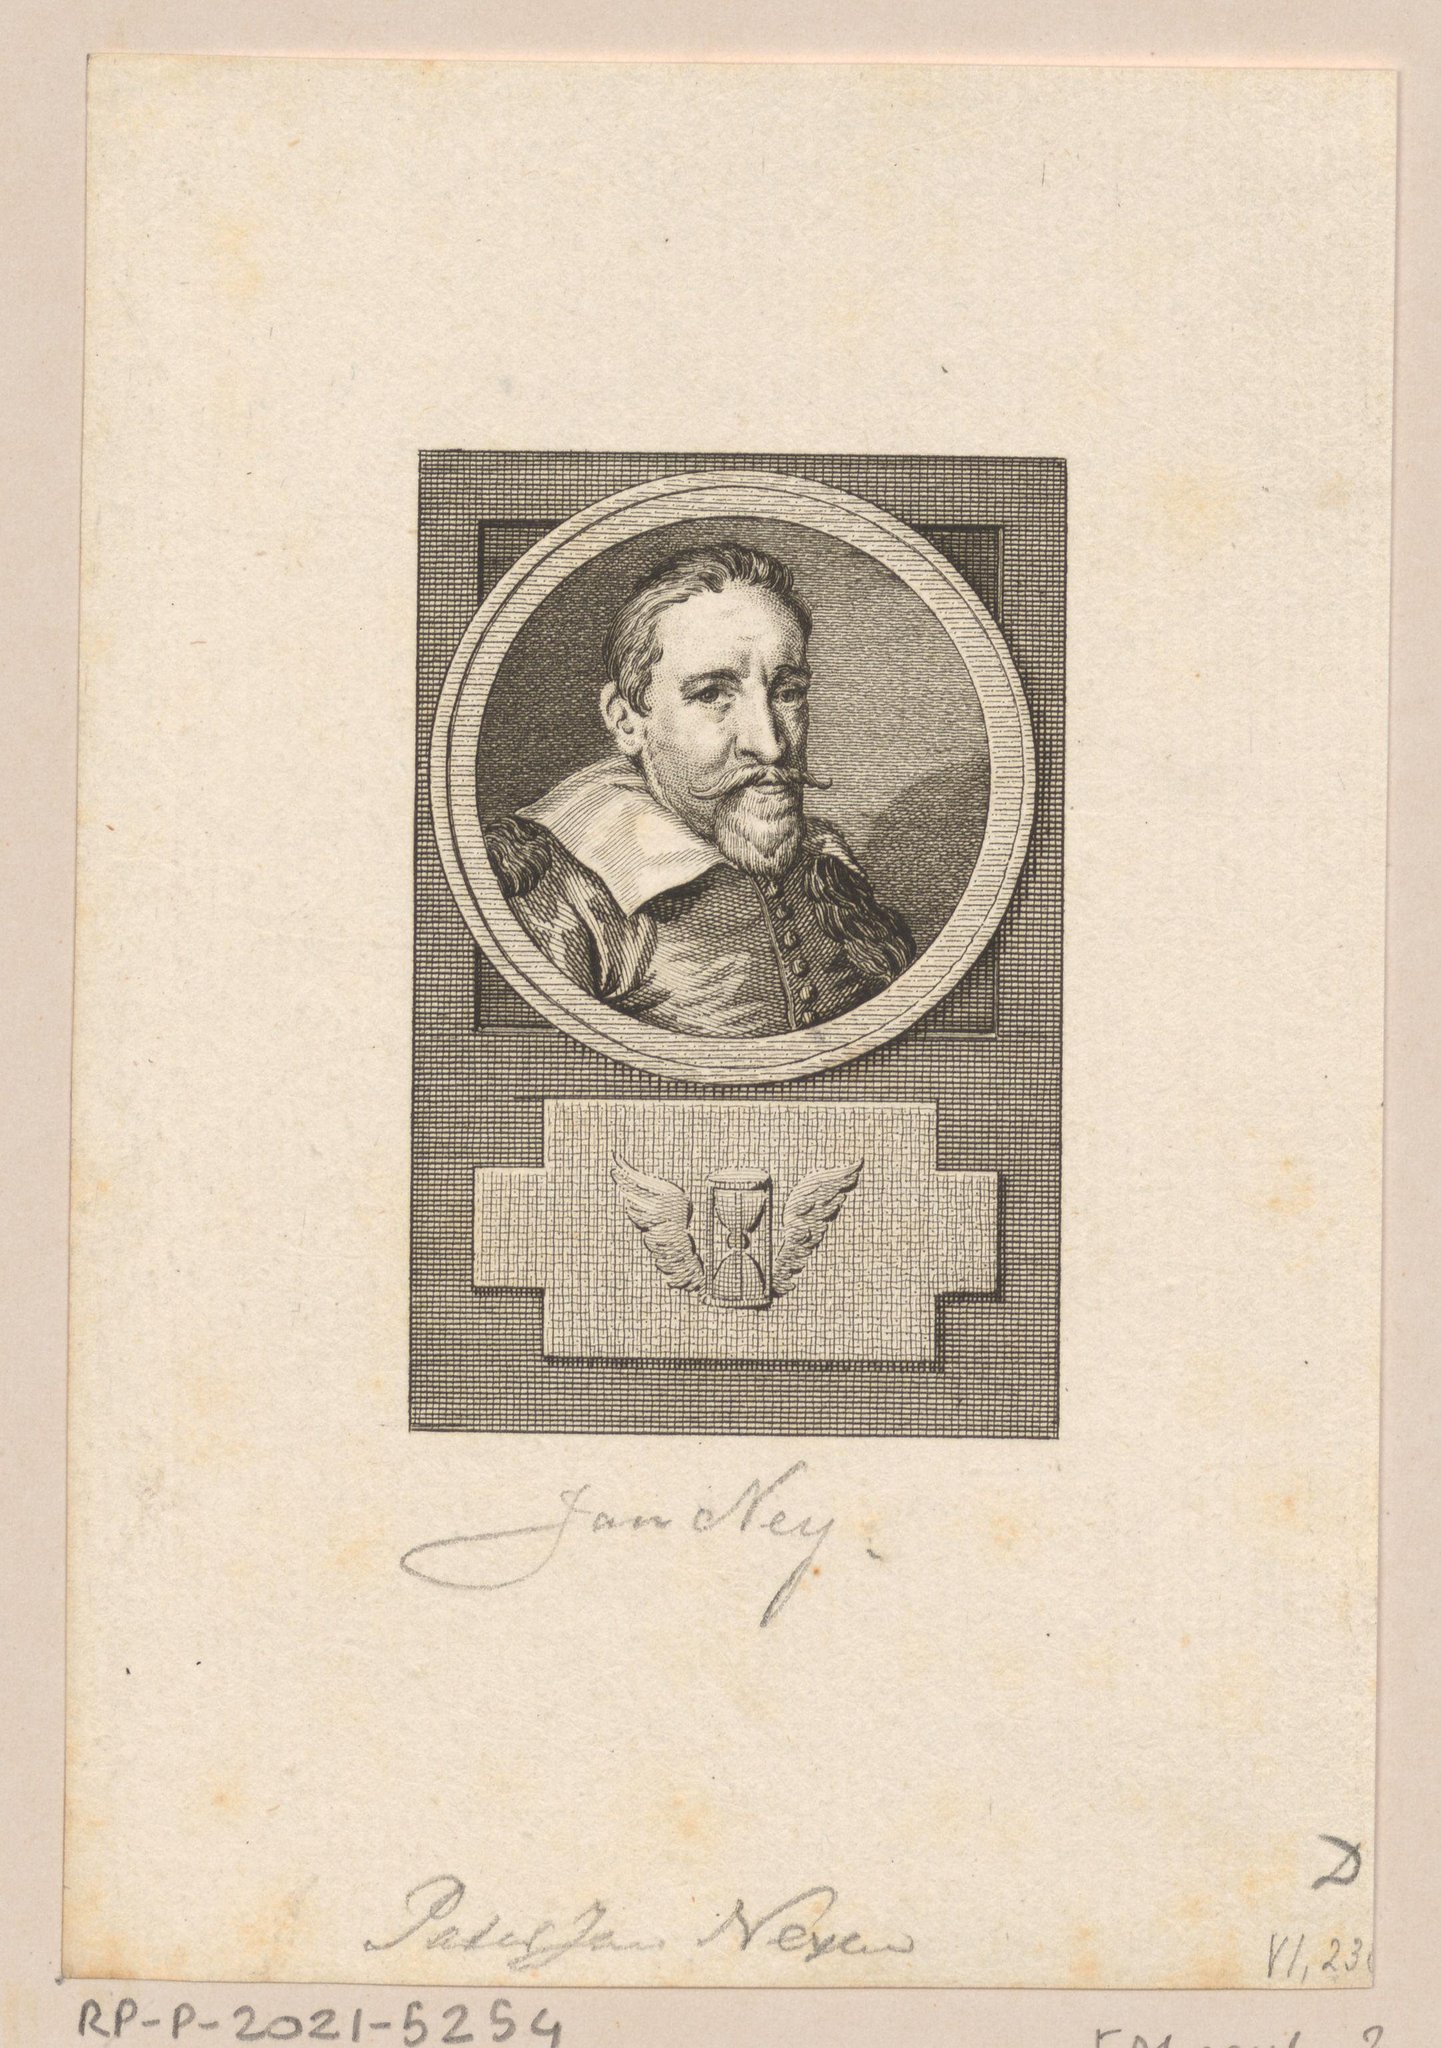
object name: print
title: Portret van Jan Neyen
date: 1783-1795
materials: paper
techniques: engraving, etching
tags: antwerp, spain, historical persons, hourglass, diplomacy, diplomat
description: Latere staat van prent gebruikt in: Fokke, Jan. Geschiedenissen der Vereenigde Nederlanden voor de vaderlandsche jeugd (...). Amsterdam: Johannes Allart, 1783-1795, dl. 6.